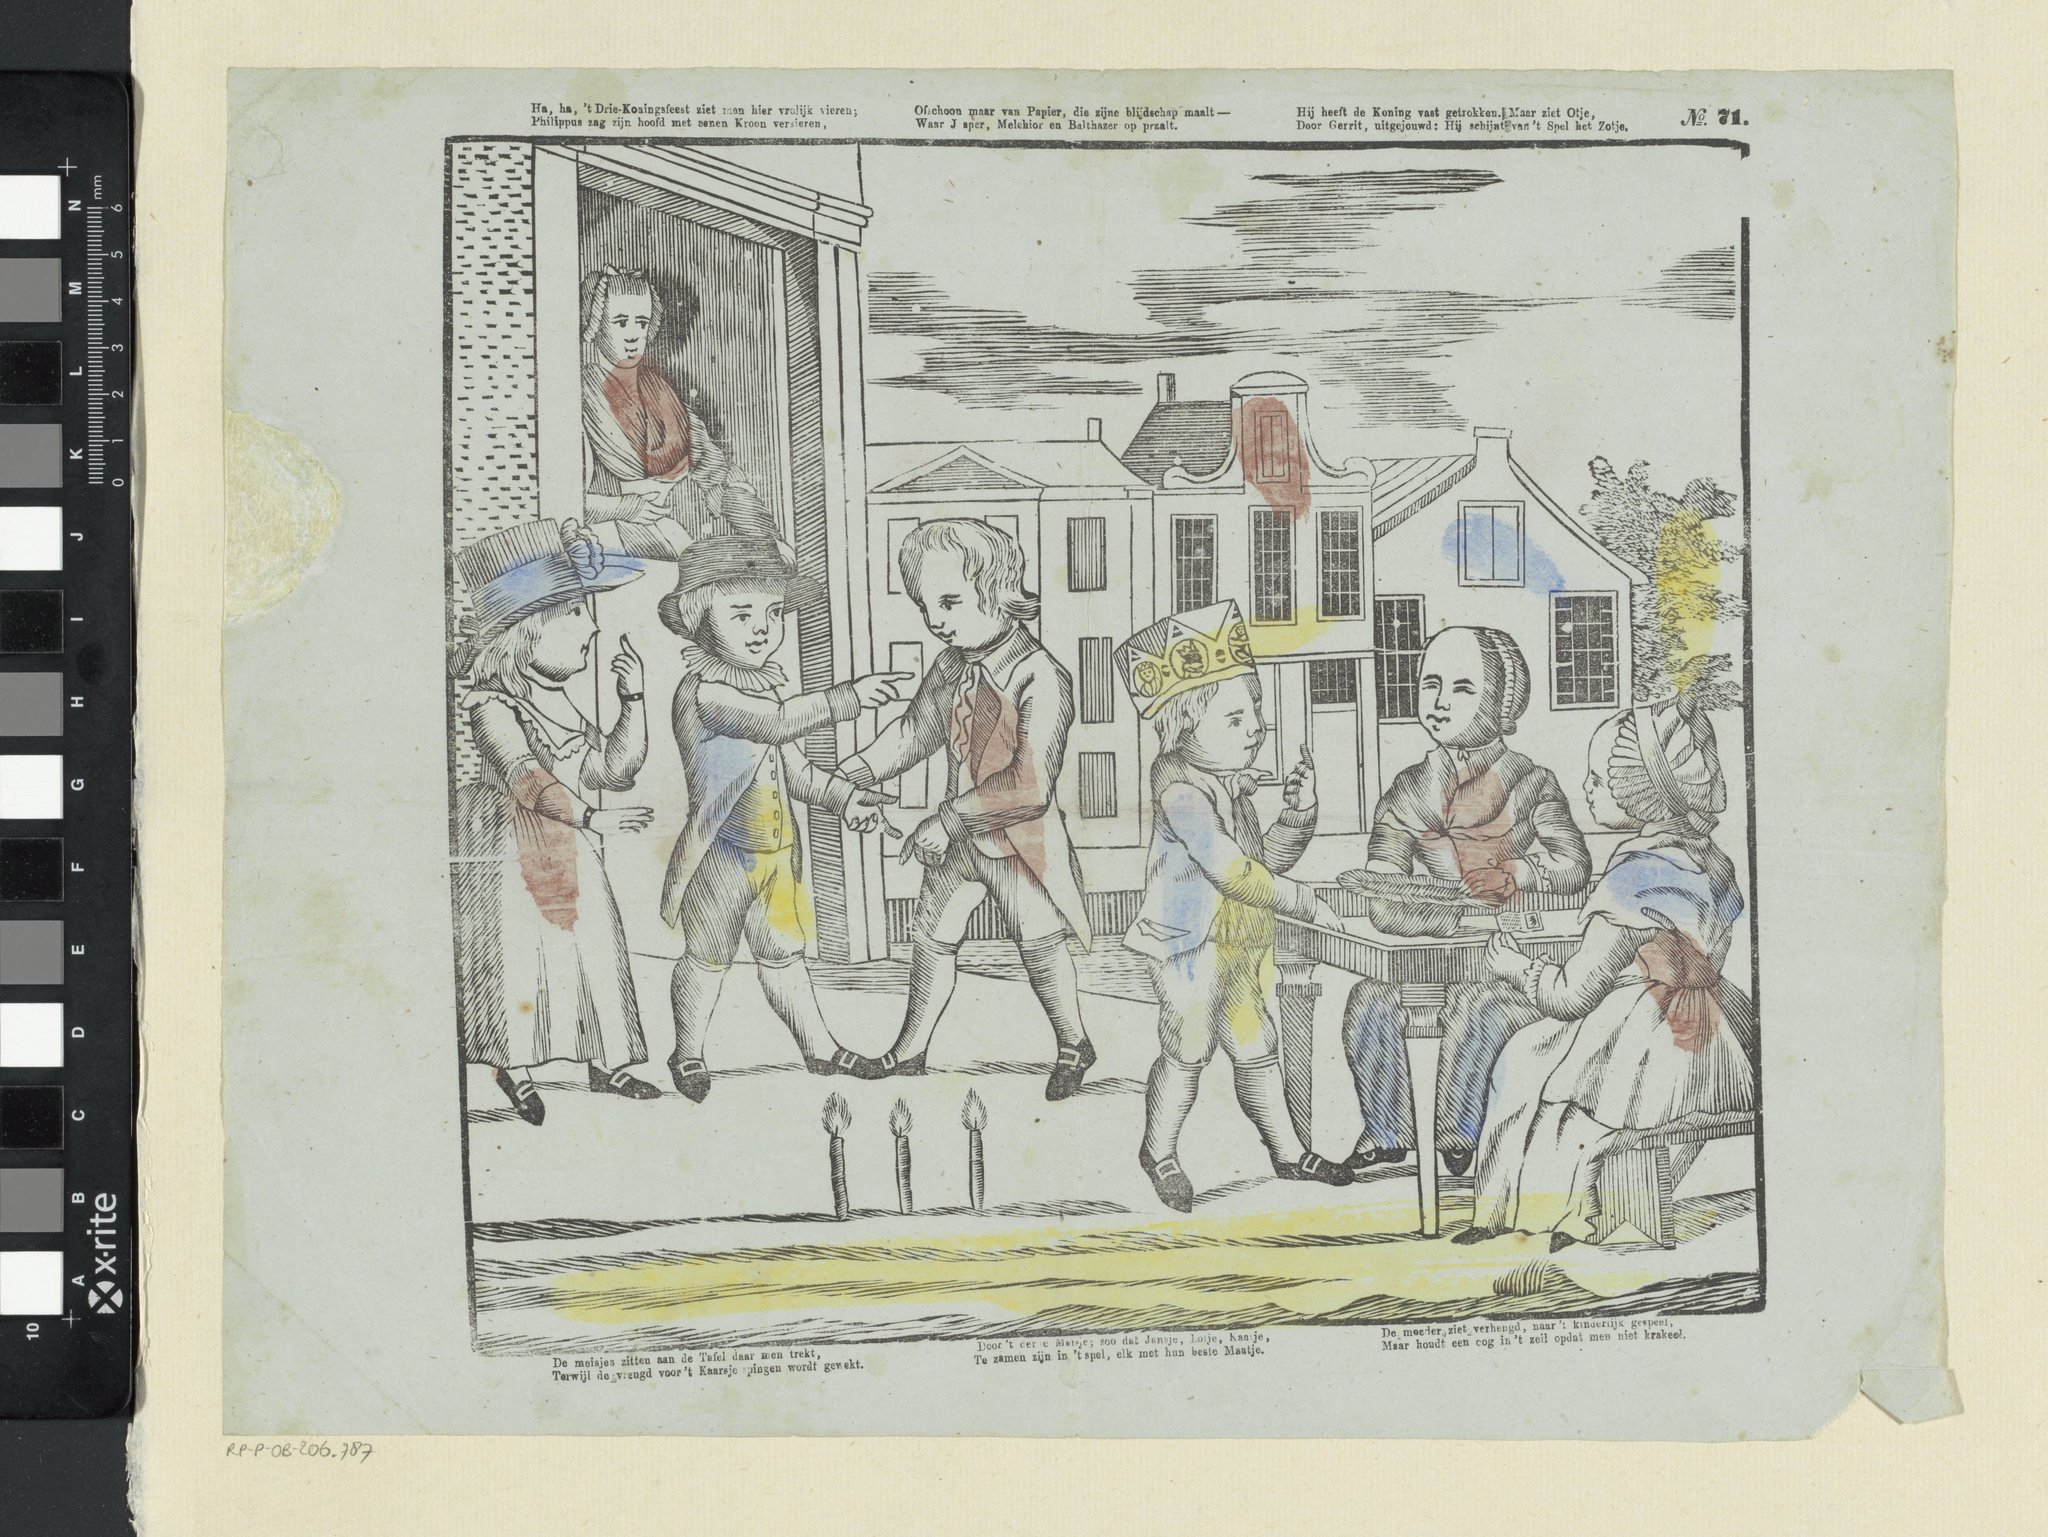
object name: print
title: Ha, ha, 't Drie-Koningsfeest ziet men hier vrolijk vieren; / Philippus zag zijn hoofd met eenen kroon versieren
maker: Anonymous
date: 1850-1870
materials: paper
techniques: colour, letterpress printing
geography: netherlands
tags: children's games and plays, twelfth night, usually falling on the eve of january 6, royal household; courtiers, retinue, train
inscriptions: collector's mark: Lugt 2760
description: Blad met een grote voorstelling van zes kinderen die het spel koning-trekken spelen op het Driekoningenfeest. Moeder kijkt vanaf een afstandje toe. Onder de afbeelding een zesregelig vers in twee kolommen. Genummerd rechtsboven: No. 71.